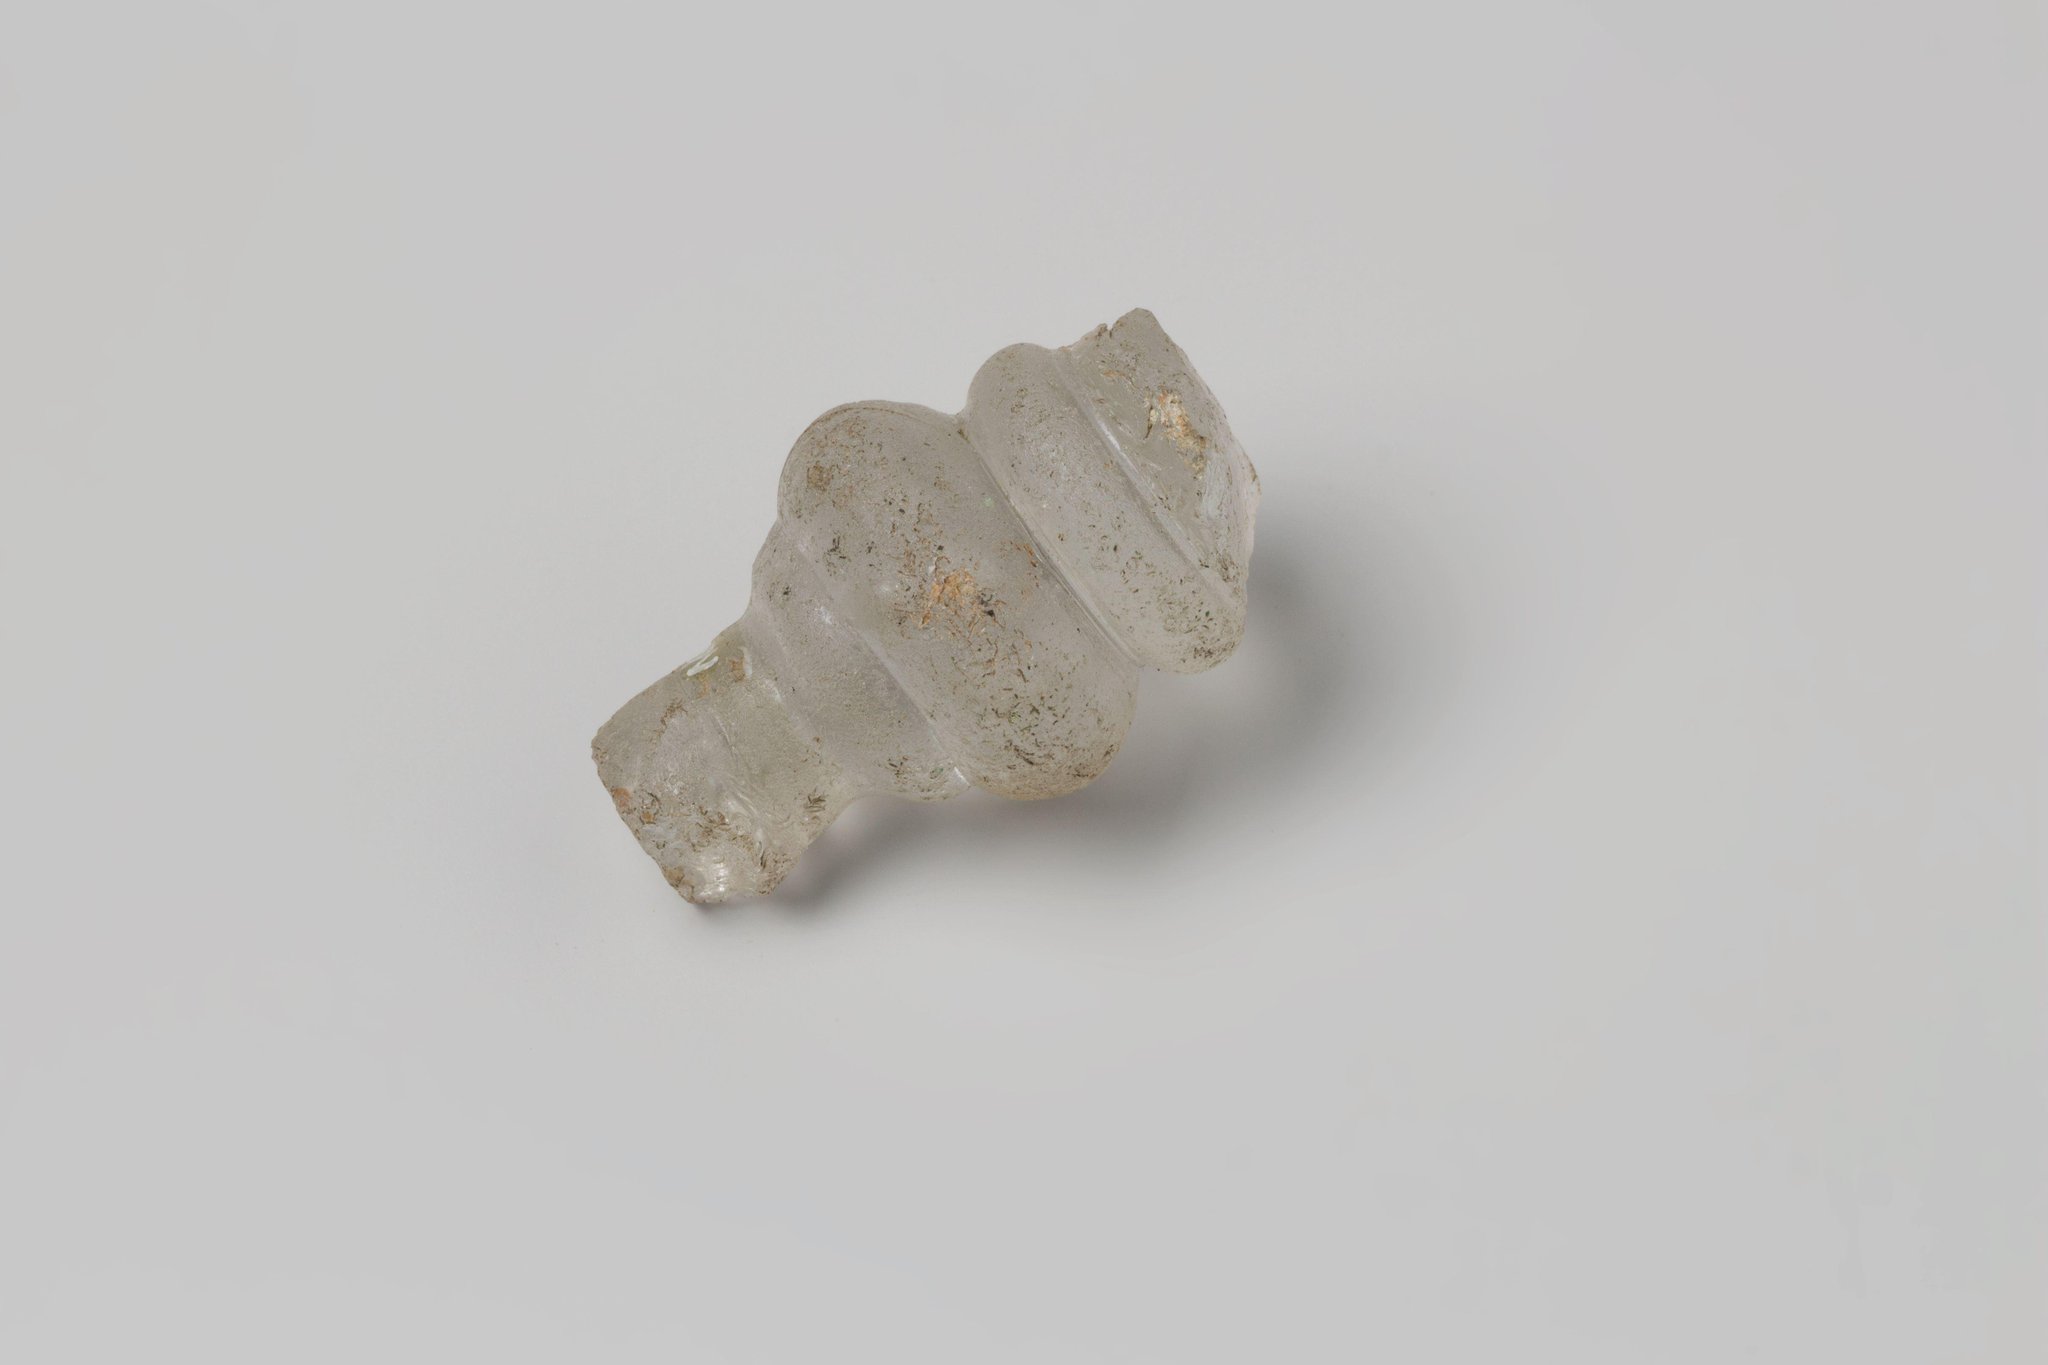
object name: helve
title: Fragment balustervormige steel van een fluitglas uit het wrak van de Oost-Indiëvaarder Hollandia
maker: Anonymous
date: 1700-1743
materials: glass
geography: netherlands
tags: verenigde oostindische compagnie, hollandia (schip), annet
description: Glass, stem glass, steel, baluster-shaped; fragment, solid, consisting of a flattened knop and 2 rings, upper end concave, broken off, at other end short straight shaft, broken off.